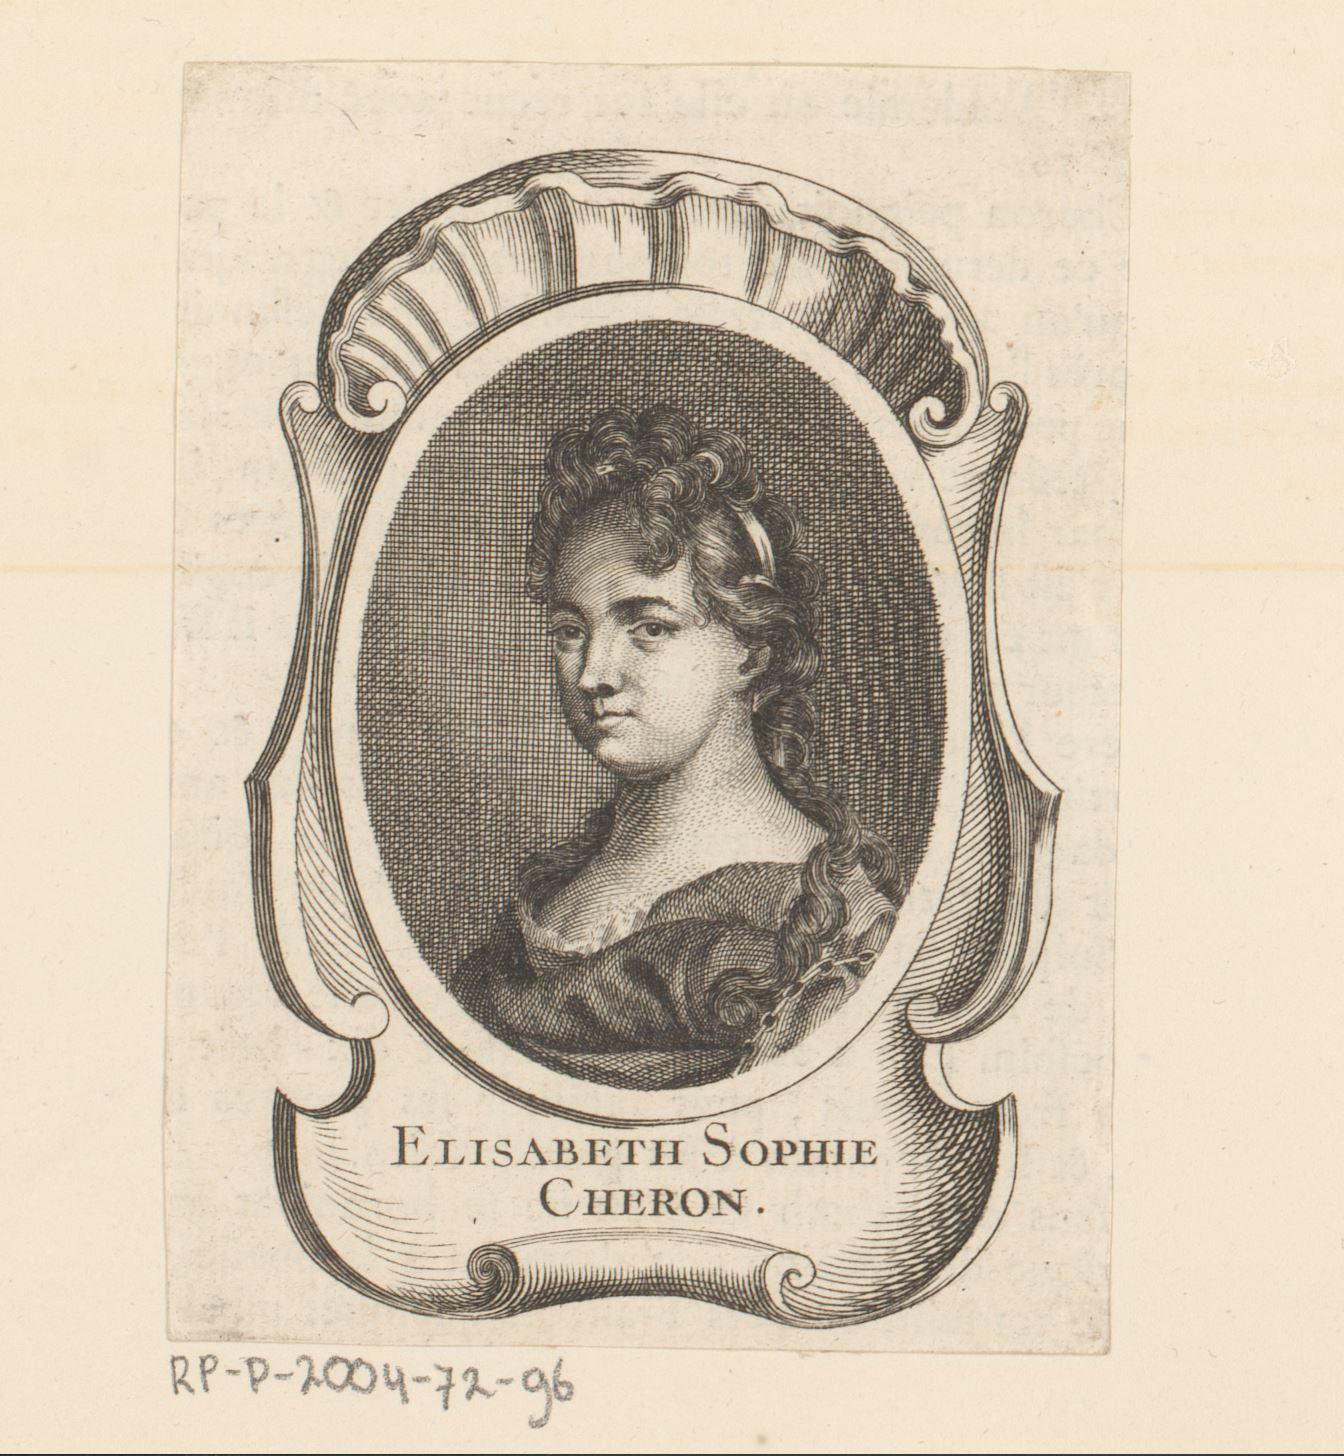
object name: album leaf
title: Portret van Elisabeth Sophie Chéron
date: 1745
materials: paper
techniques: engraving, letterpress printing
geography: paris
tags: painter, elisabeth sophie chéron, historical persons, portrait, self-portrait of painter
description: Prent uit: Dézallier d'Argenville, Antoine Joseph. Abrégé de la vie des plus fameux peintres. 4 dln. Parijs: De Bure l'aîné, 1745, dl. 2, p. 369. De samensteller heeft deze prent in het album geplakt als illustratie bij: Pilkington, Matthew en Johann Heinrich Füssli. A dictionary of painters, from the revival of the art to the present period. 4 dln. Londen: John Crowder, 1805, dl. 1, p. 121.